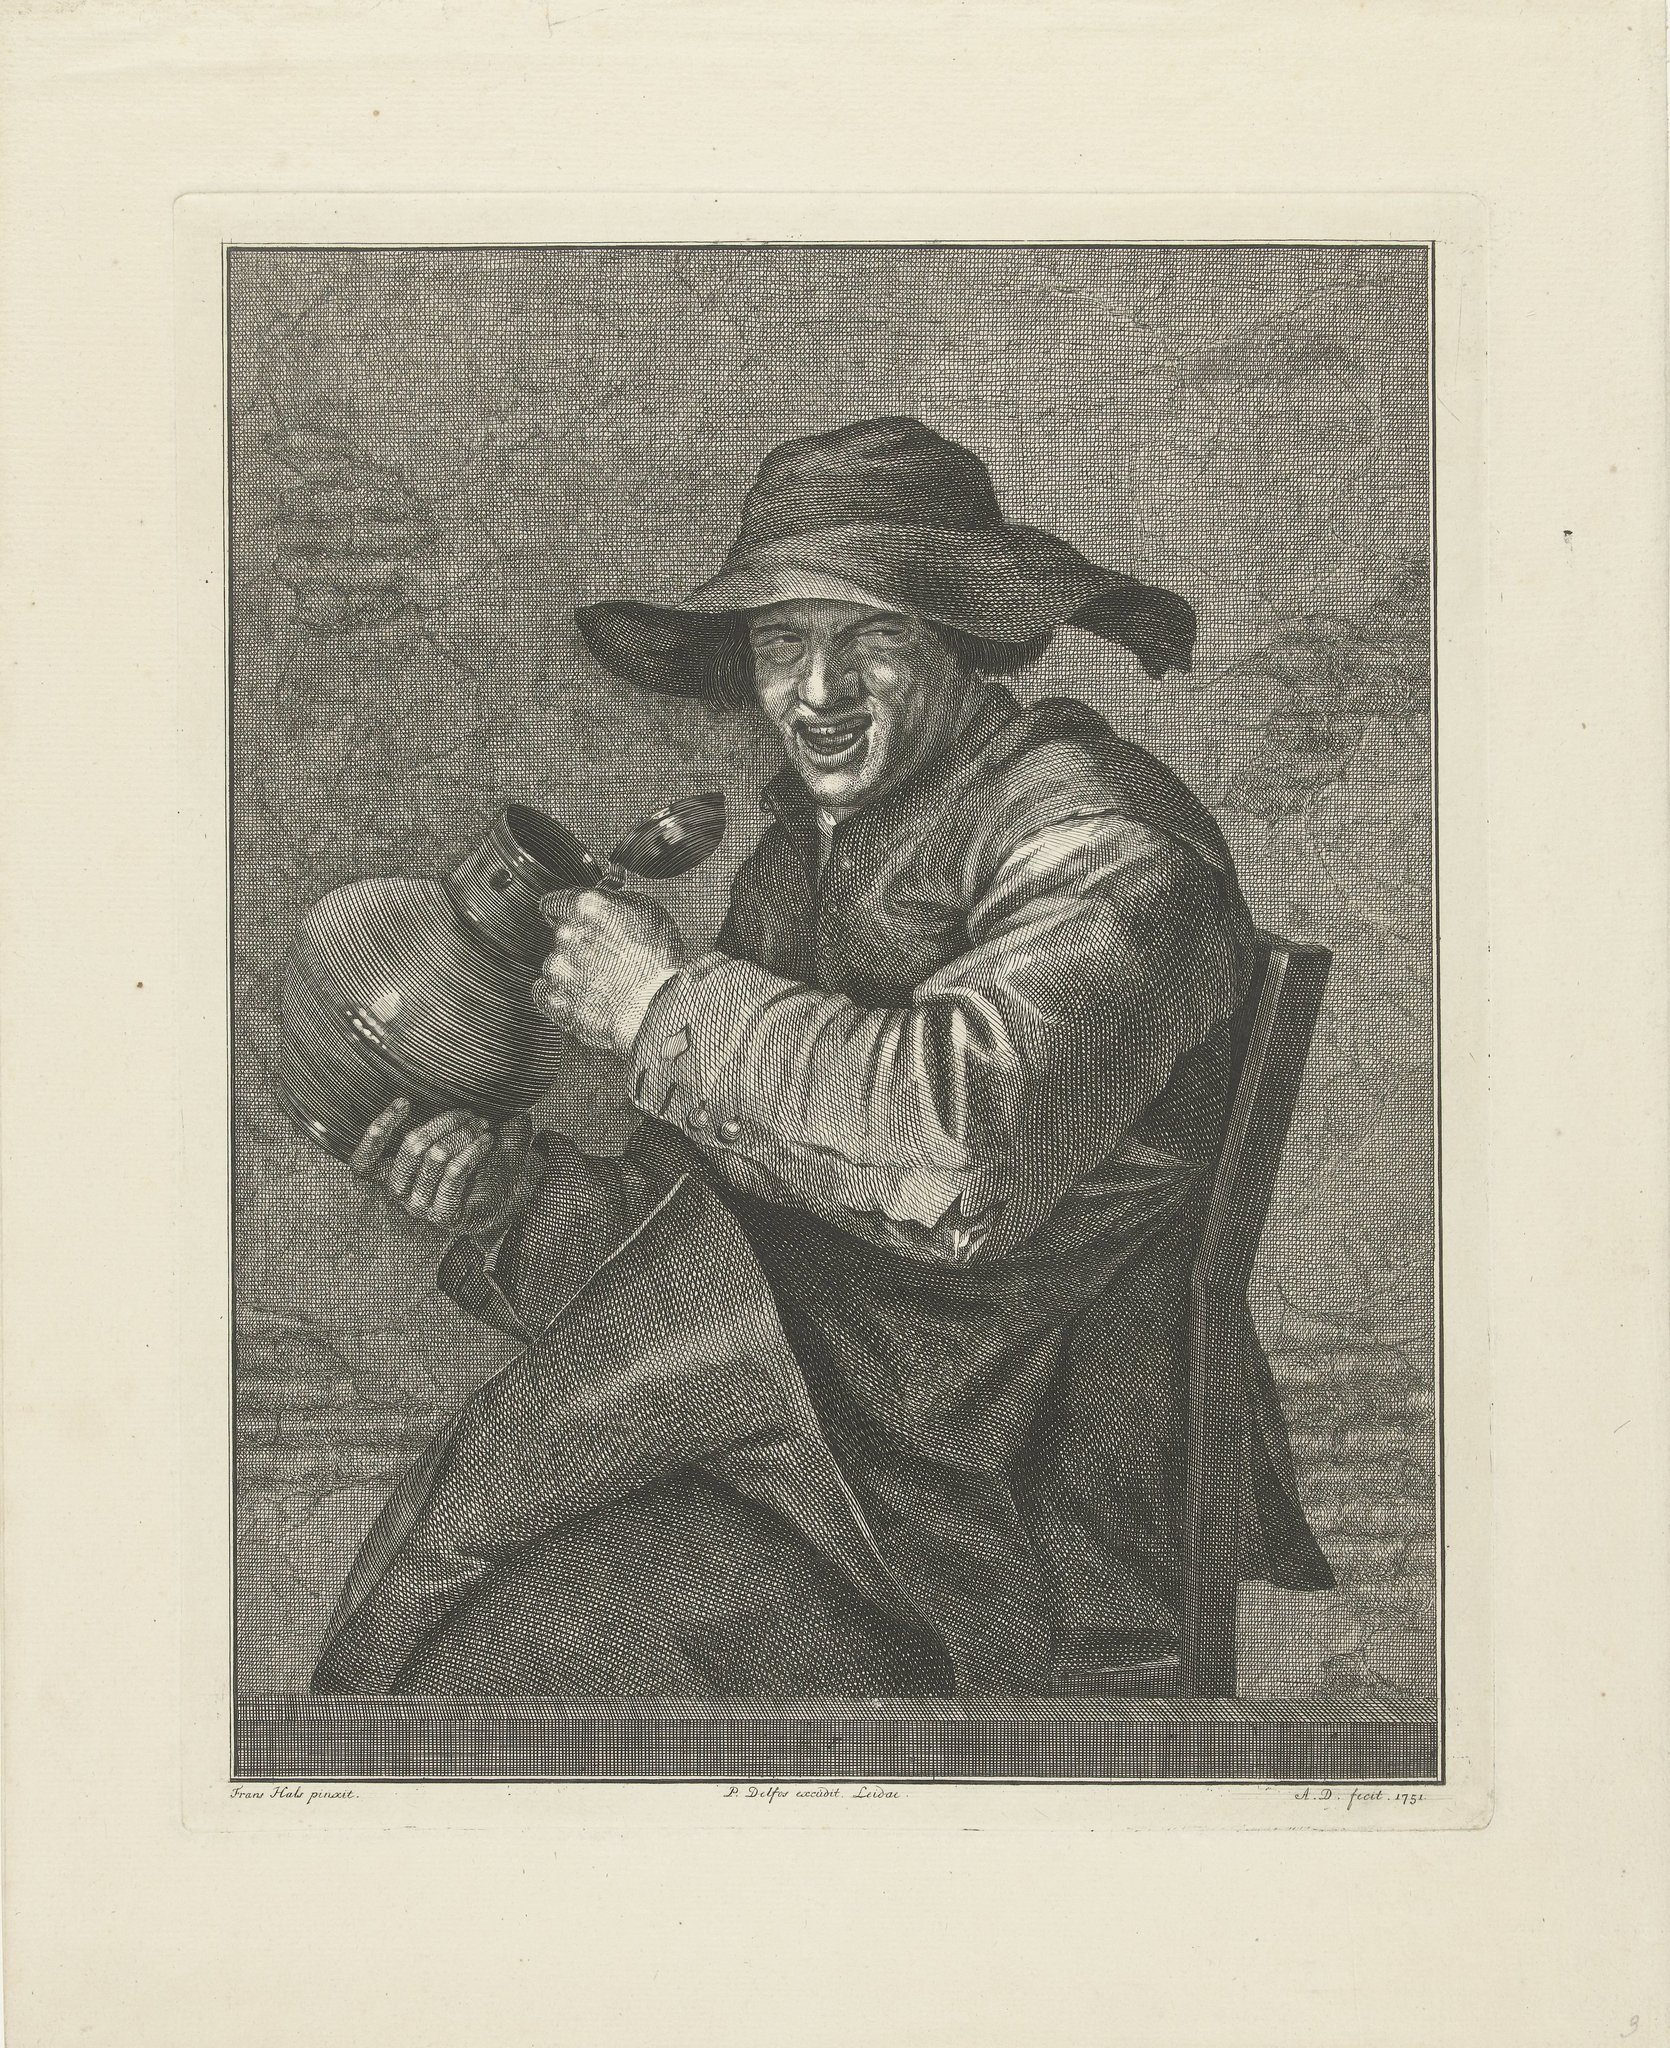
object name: print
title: Lachende man op stoel met kan in zijn hand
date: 1751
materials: paper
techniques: etching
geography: leiden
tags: laughing, foodstuffs; still life of foodstuffs (+ taking (particular) foodstuffs: eating, drinking, smoking, chewing, etc.)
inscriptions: collector's mark: Lugt 240